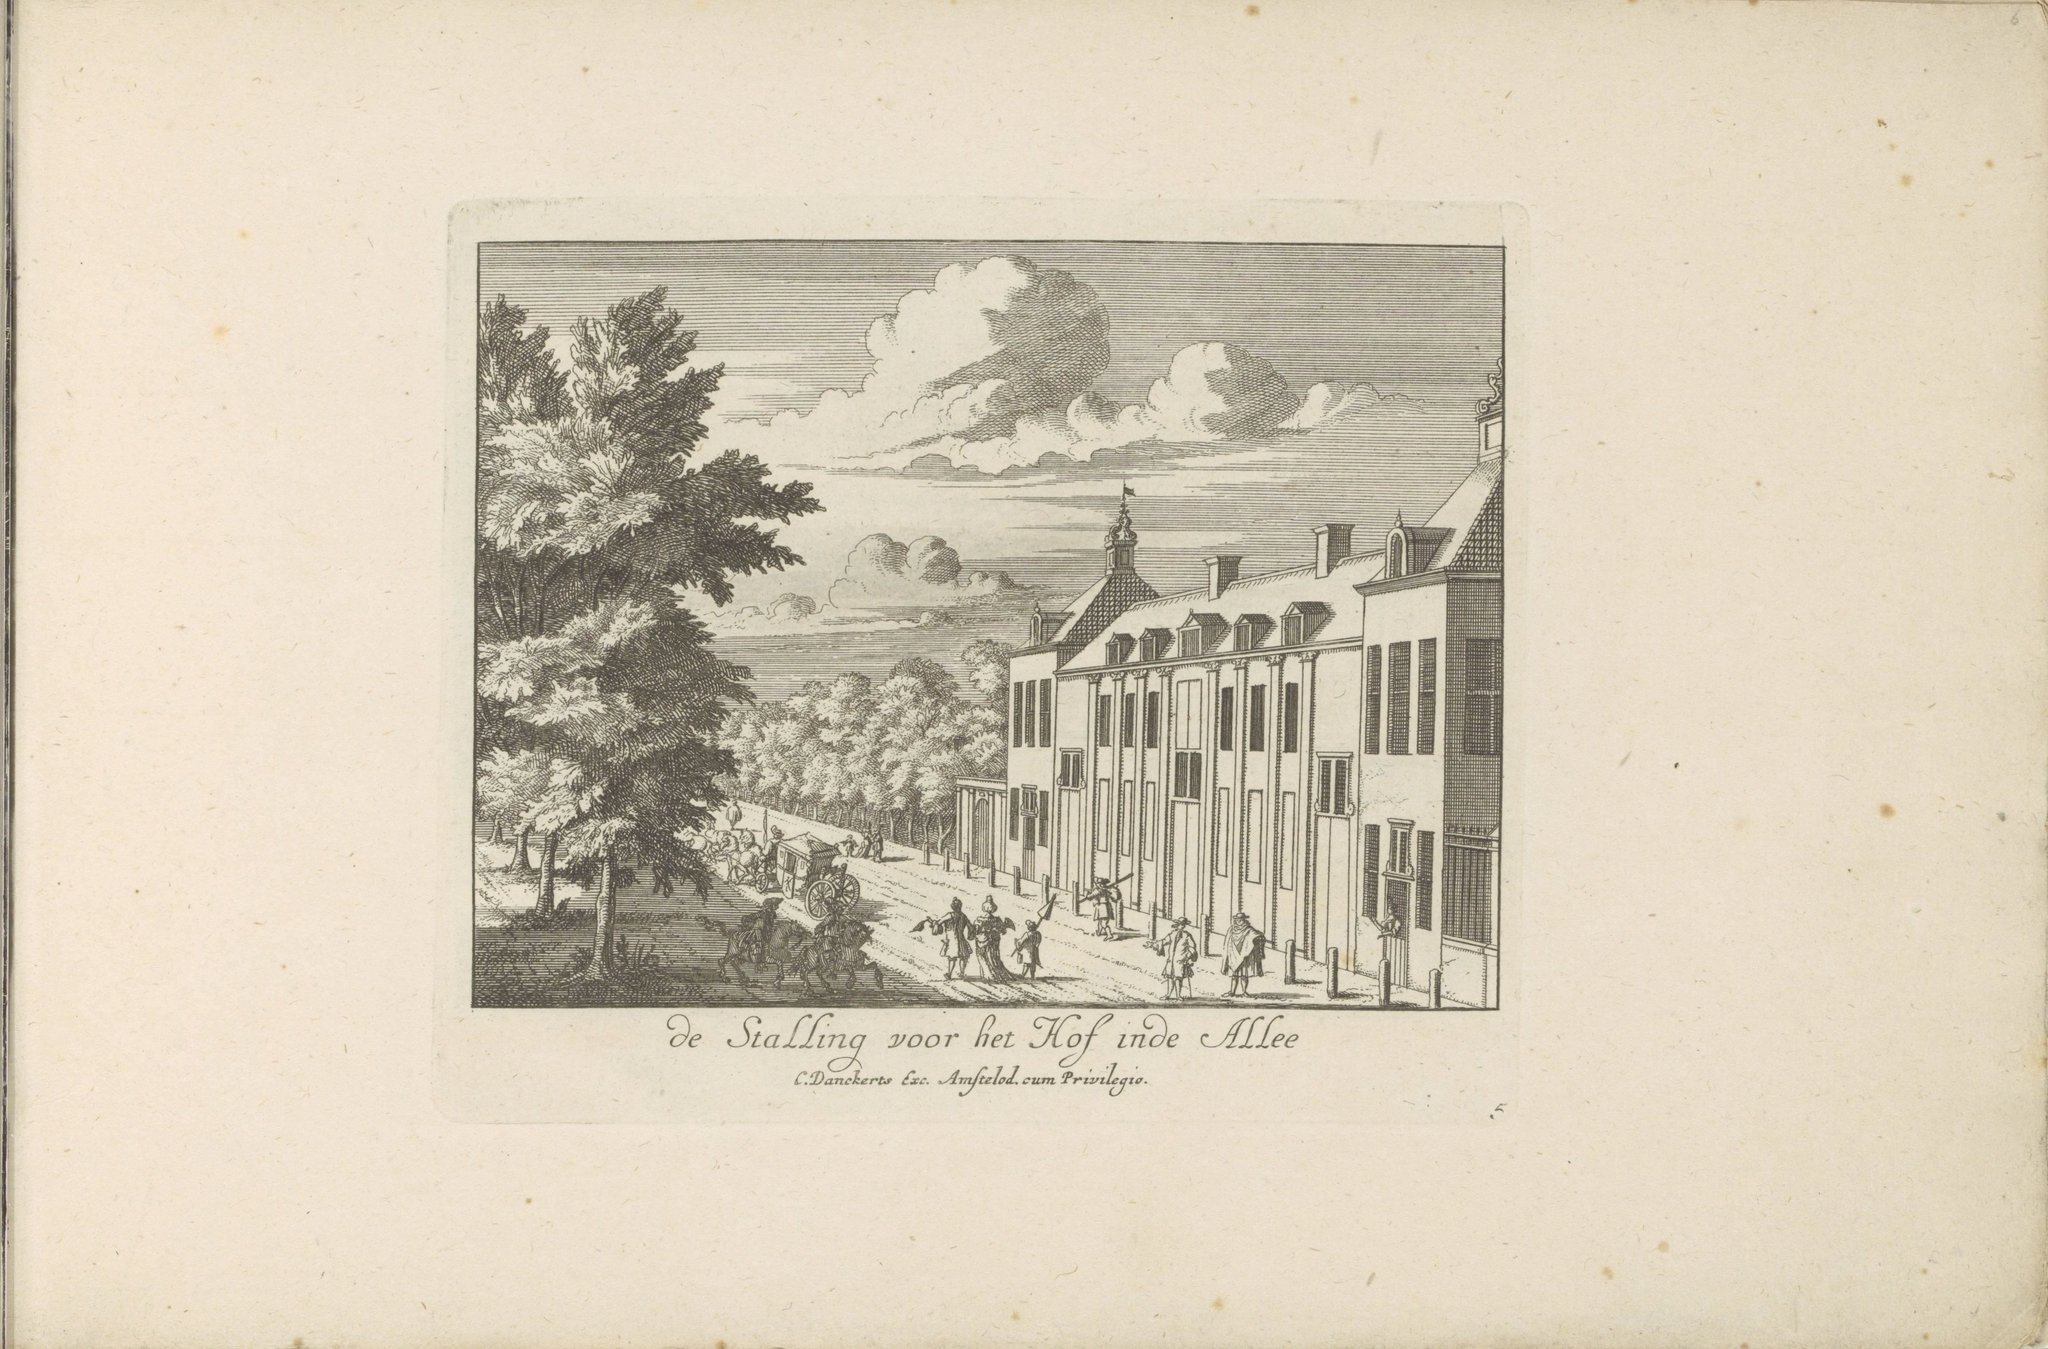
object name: album leaf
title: De Stalling voor het Hof inde Allee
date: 1696-1718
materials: paper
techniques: etching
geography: amsterdam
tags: exterior ~ representation of a building, stall, stable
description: Zicht op de stallen bij Paleis Het Loo en op de toegangsweg. Prent maakt deel uit van een album.